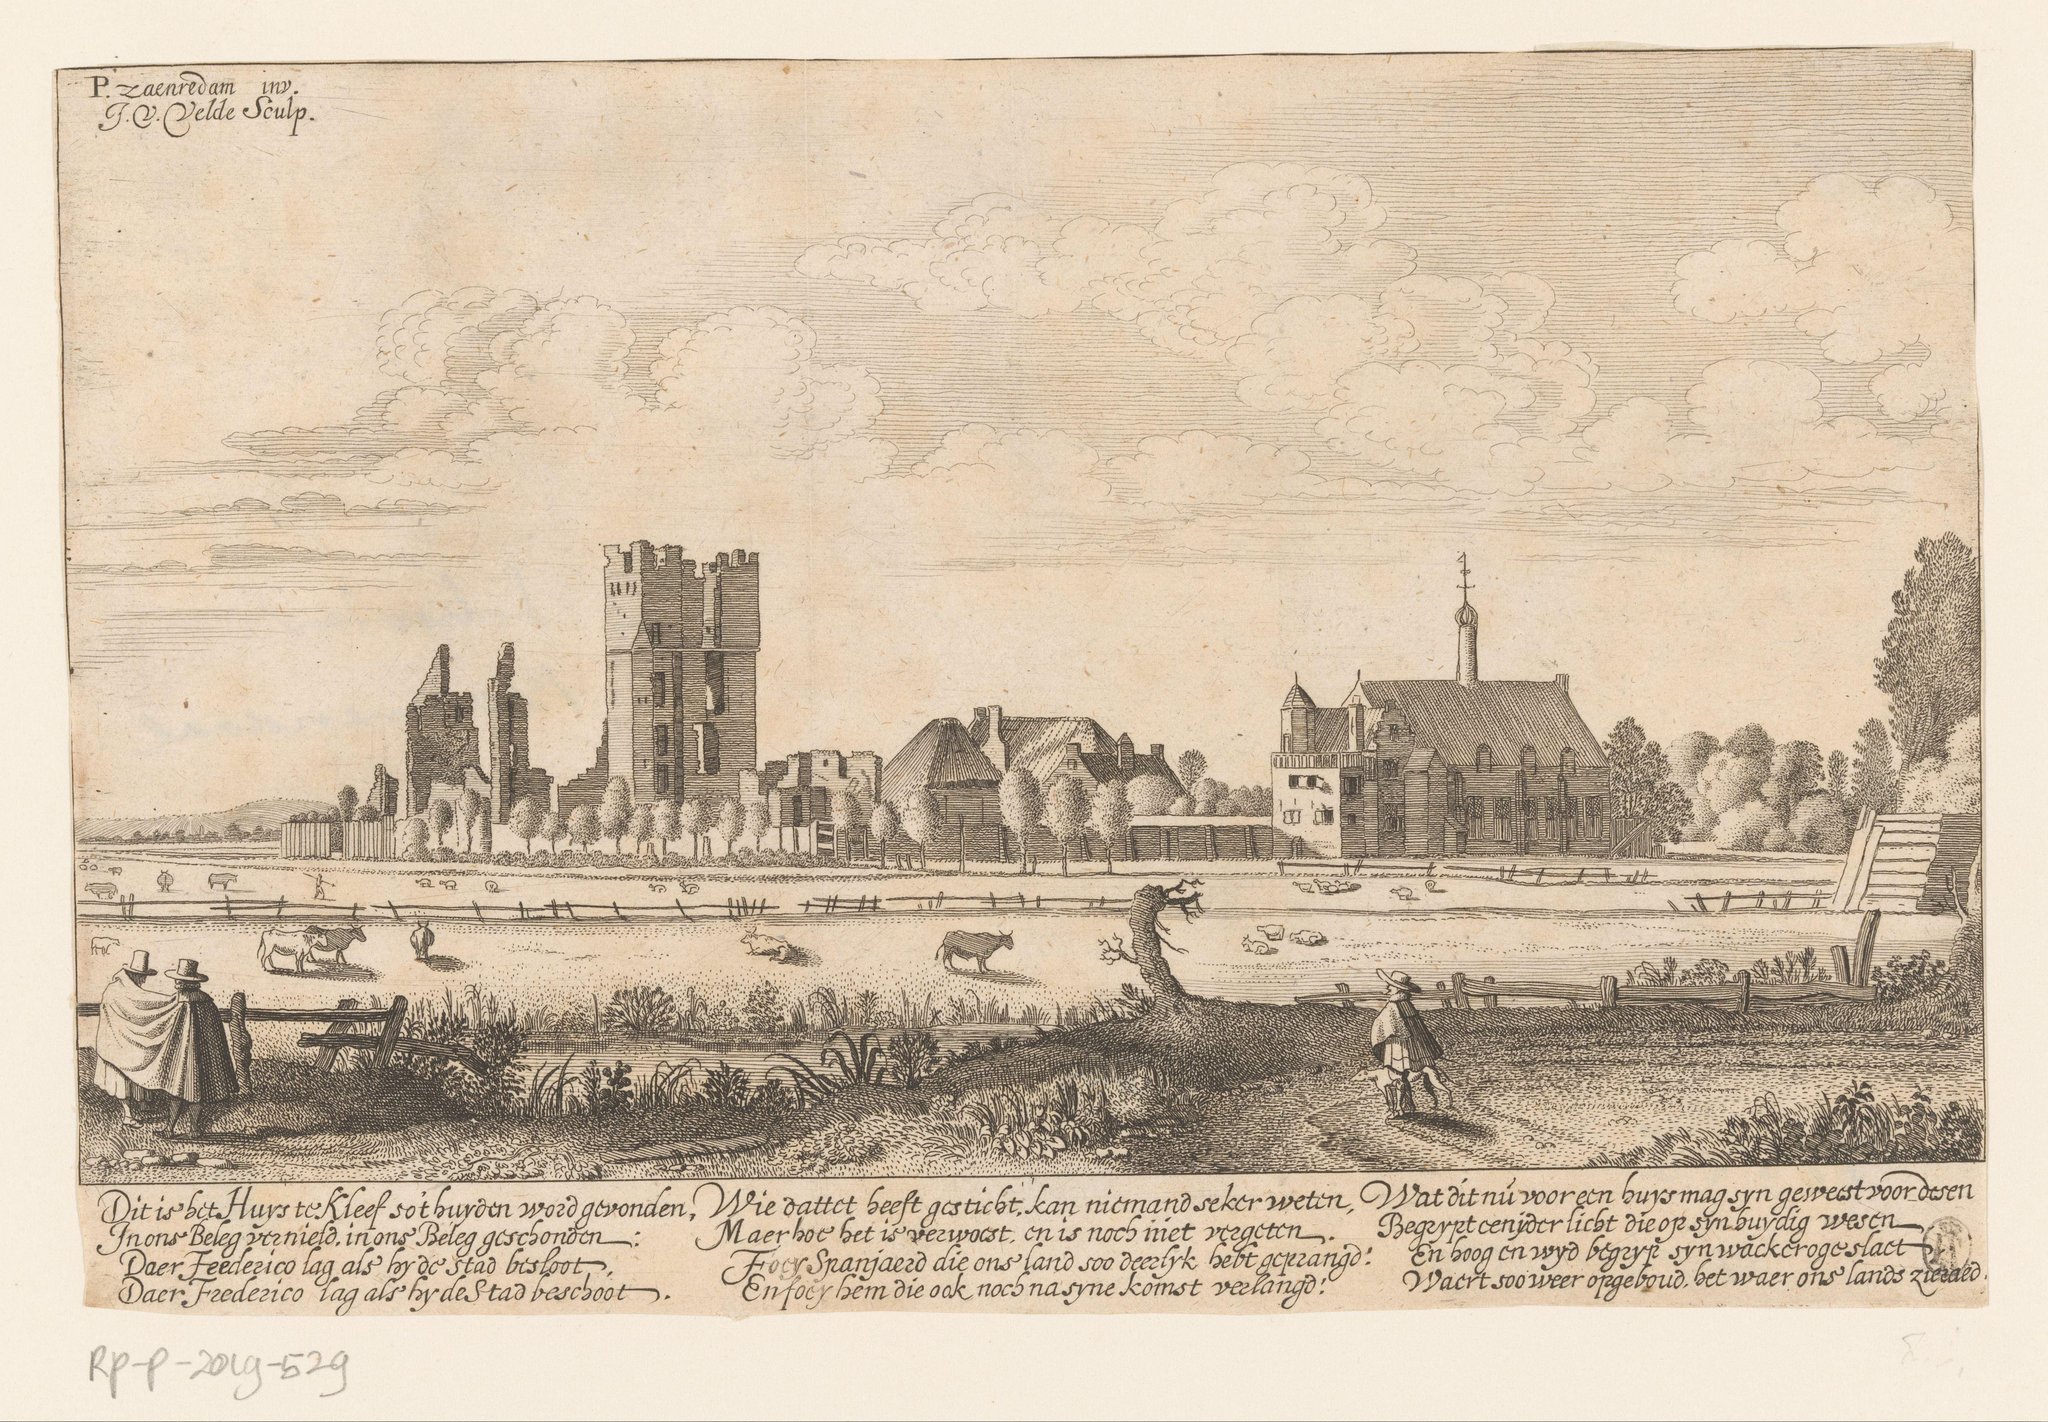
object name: book illustration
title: Gezicht op de ruïne van het Huis ter Kleef in Haarlem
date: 1628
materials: paper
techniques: etching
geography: haarlem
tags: landscape with ruins (+ city(-scape) with figures, staffage), ruin of a dwelling, house, castle, etc.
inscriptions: collector's mark: Lugt 971, collector's mark: Lugt 2228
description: Prent uit: Ampzing, Samuel. Beschryvinge ende lof der stad Haerlem in Holland (…). Haarlem: Adriaen Roman (I), 1628.